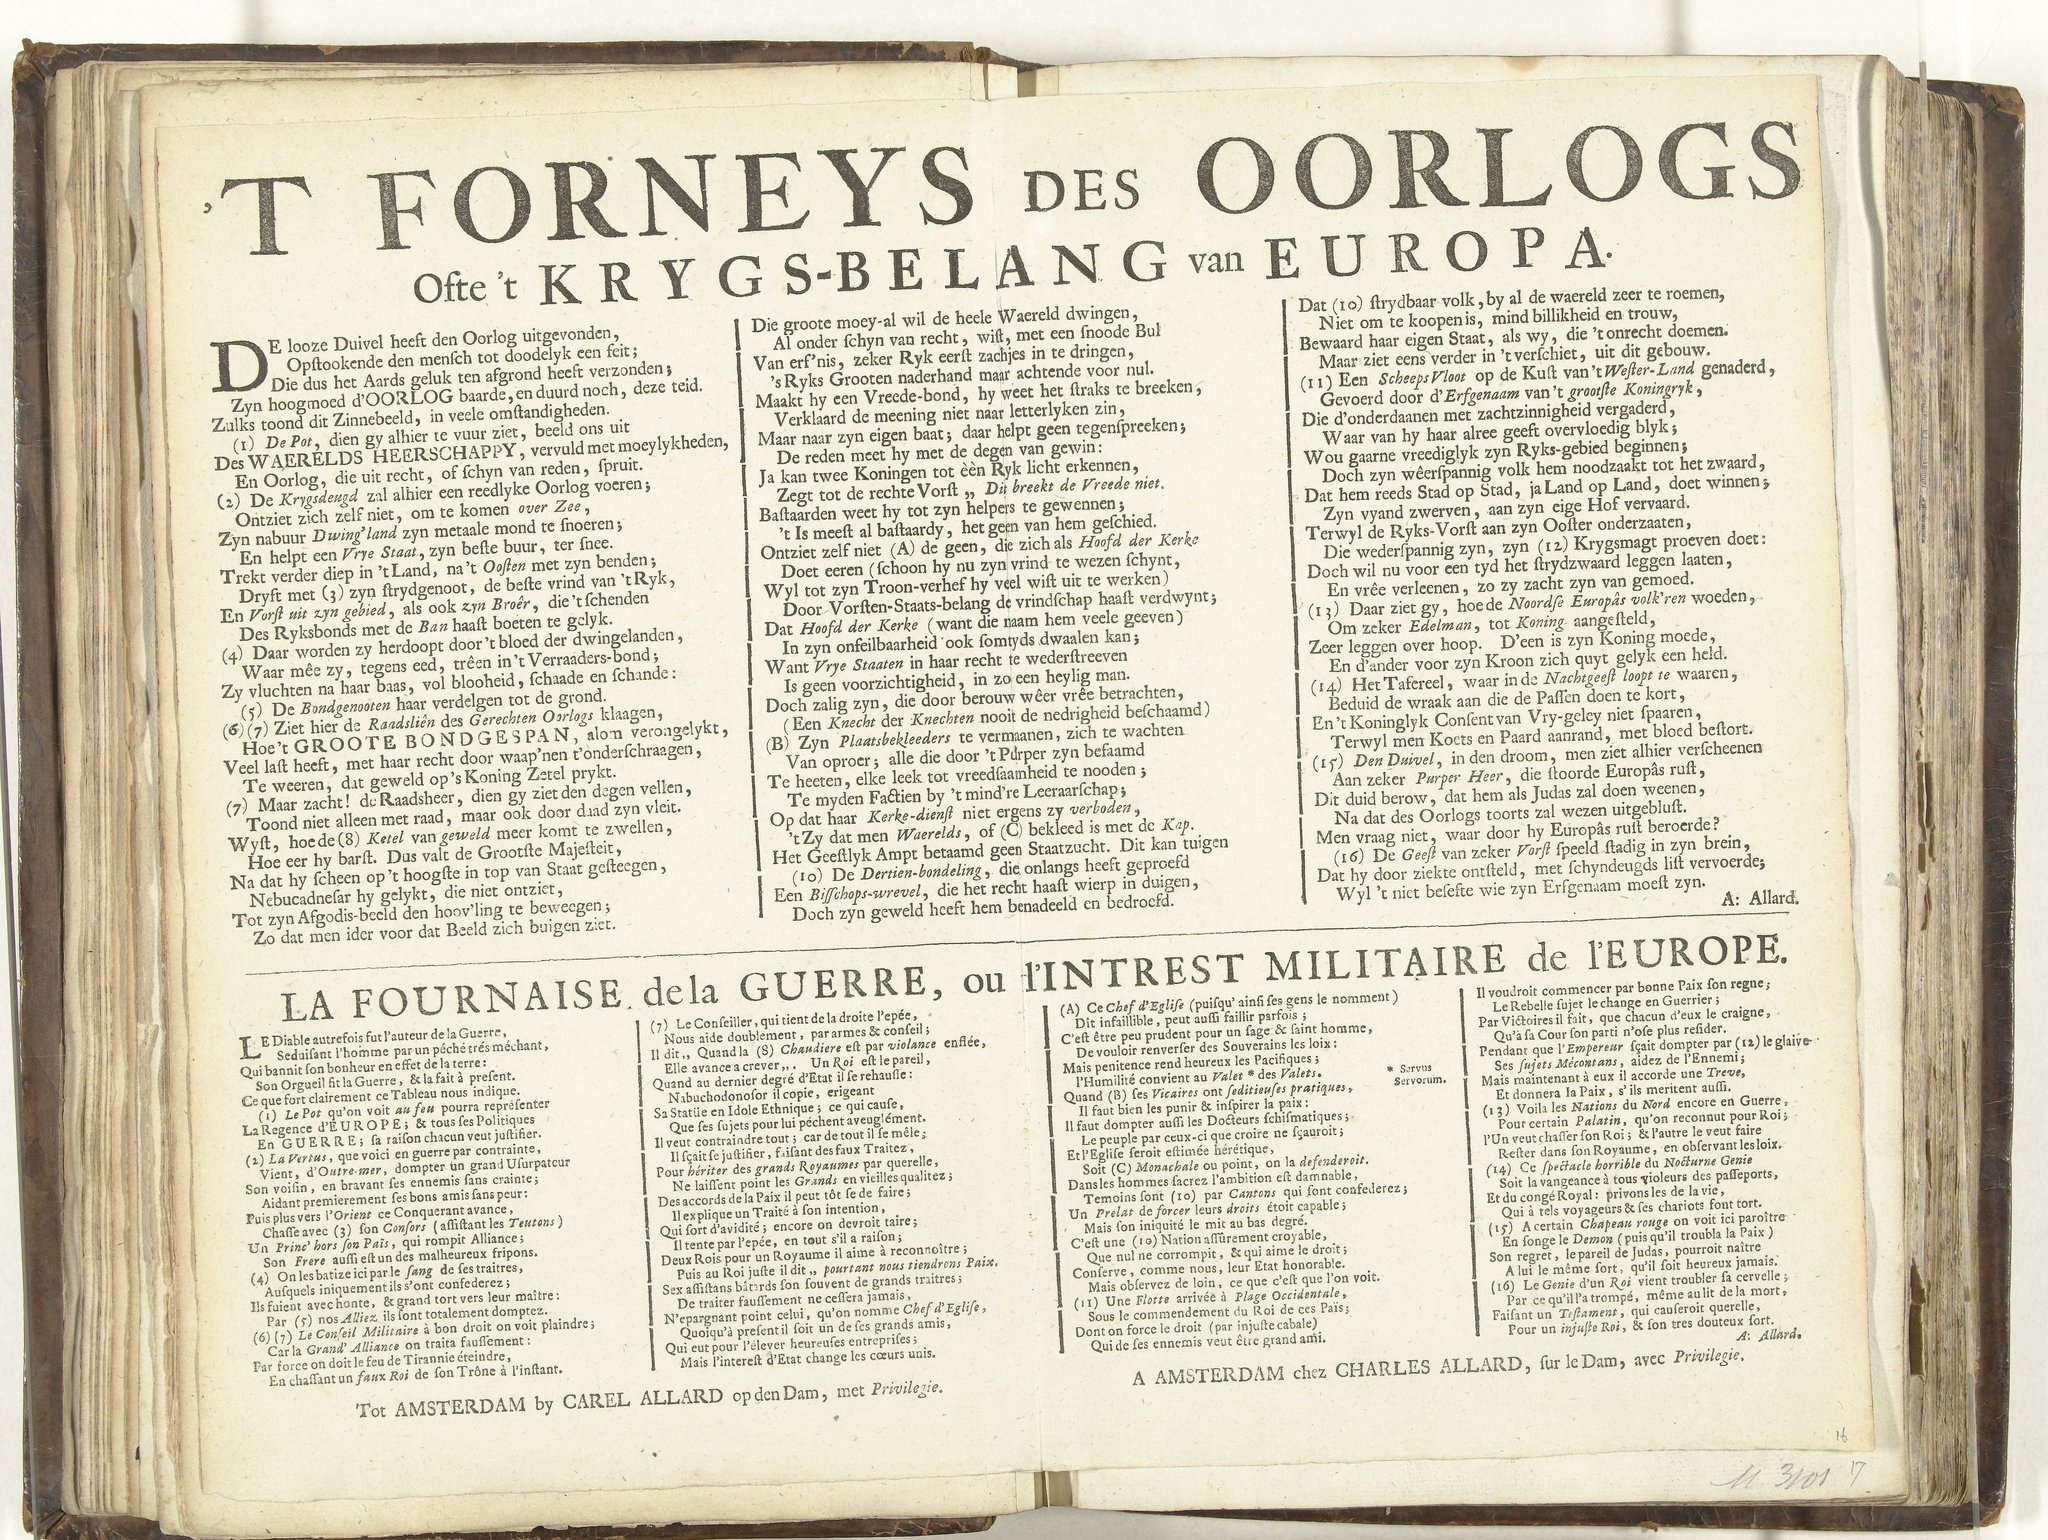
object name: text sheet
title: 4. De Blindheid of 't Forneys des Oorlogs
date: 1706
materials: paper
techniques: letterpress printing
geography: northern netherlands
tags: lodewijk xiv (koning van frankrijk)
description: Tekstblad met vers behorend bij de spotprent waarin de geallieerde Europese vorsten het Stookhuis of Fornuis van de Oorlog in de Alchemistenwerkplaats van koning Lodewijk XIV en de paus en kardinaal aan stukken slaan, 1706. Vers in 3 kolommen in het Nederlands en 4 kolommen in het Frans. Blad nr. 4 in de serie van 25 bladen getiteld: Byvoegsel tot de Koninglyke Almanach, genaamd het Gulde-Jaar der Bondgenooten, 1706. Onderdeel van het prentwerk uitgegeven onder de verzameltitel: 't Lust-Hof van Momus, met de gebundelde series van spotprenten tijdens de jaren 1701-1713 van de Spaanse Successieoorlog.